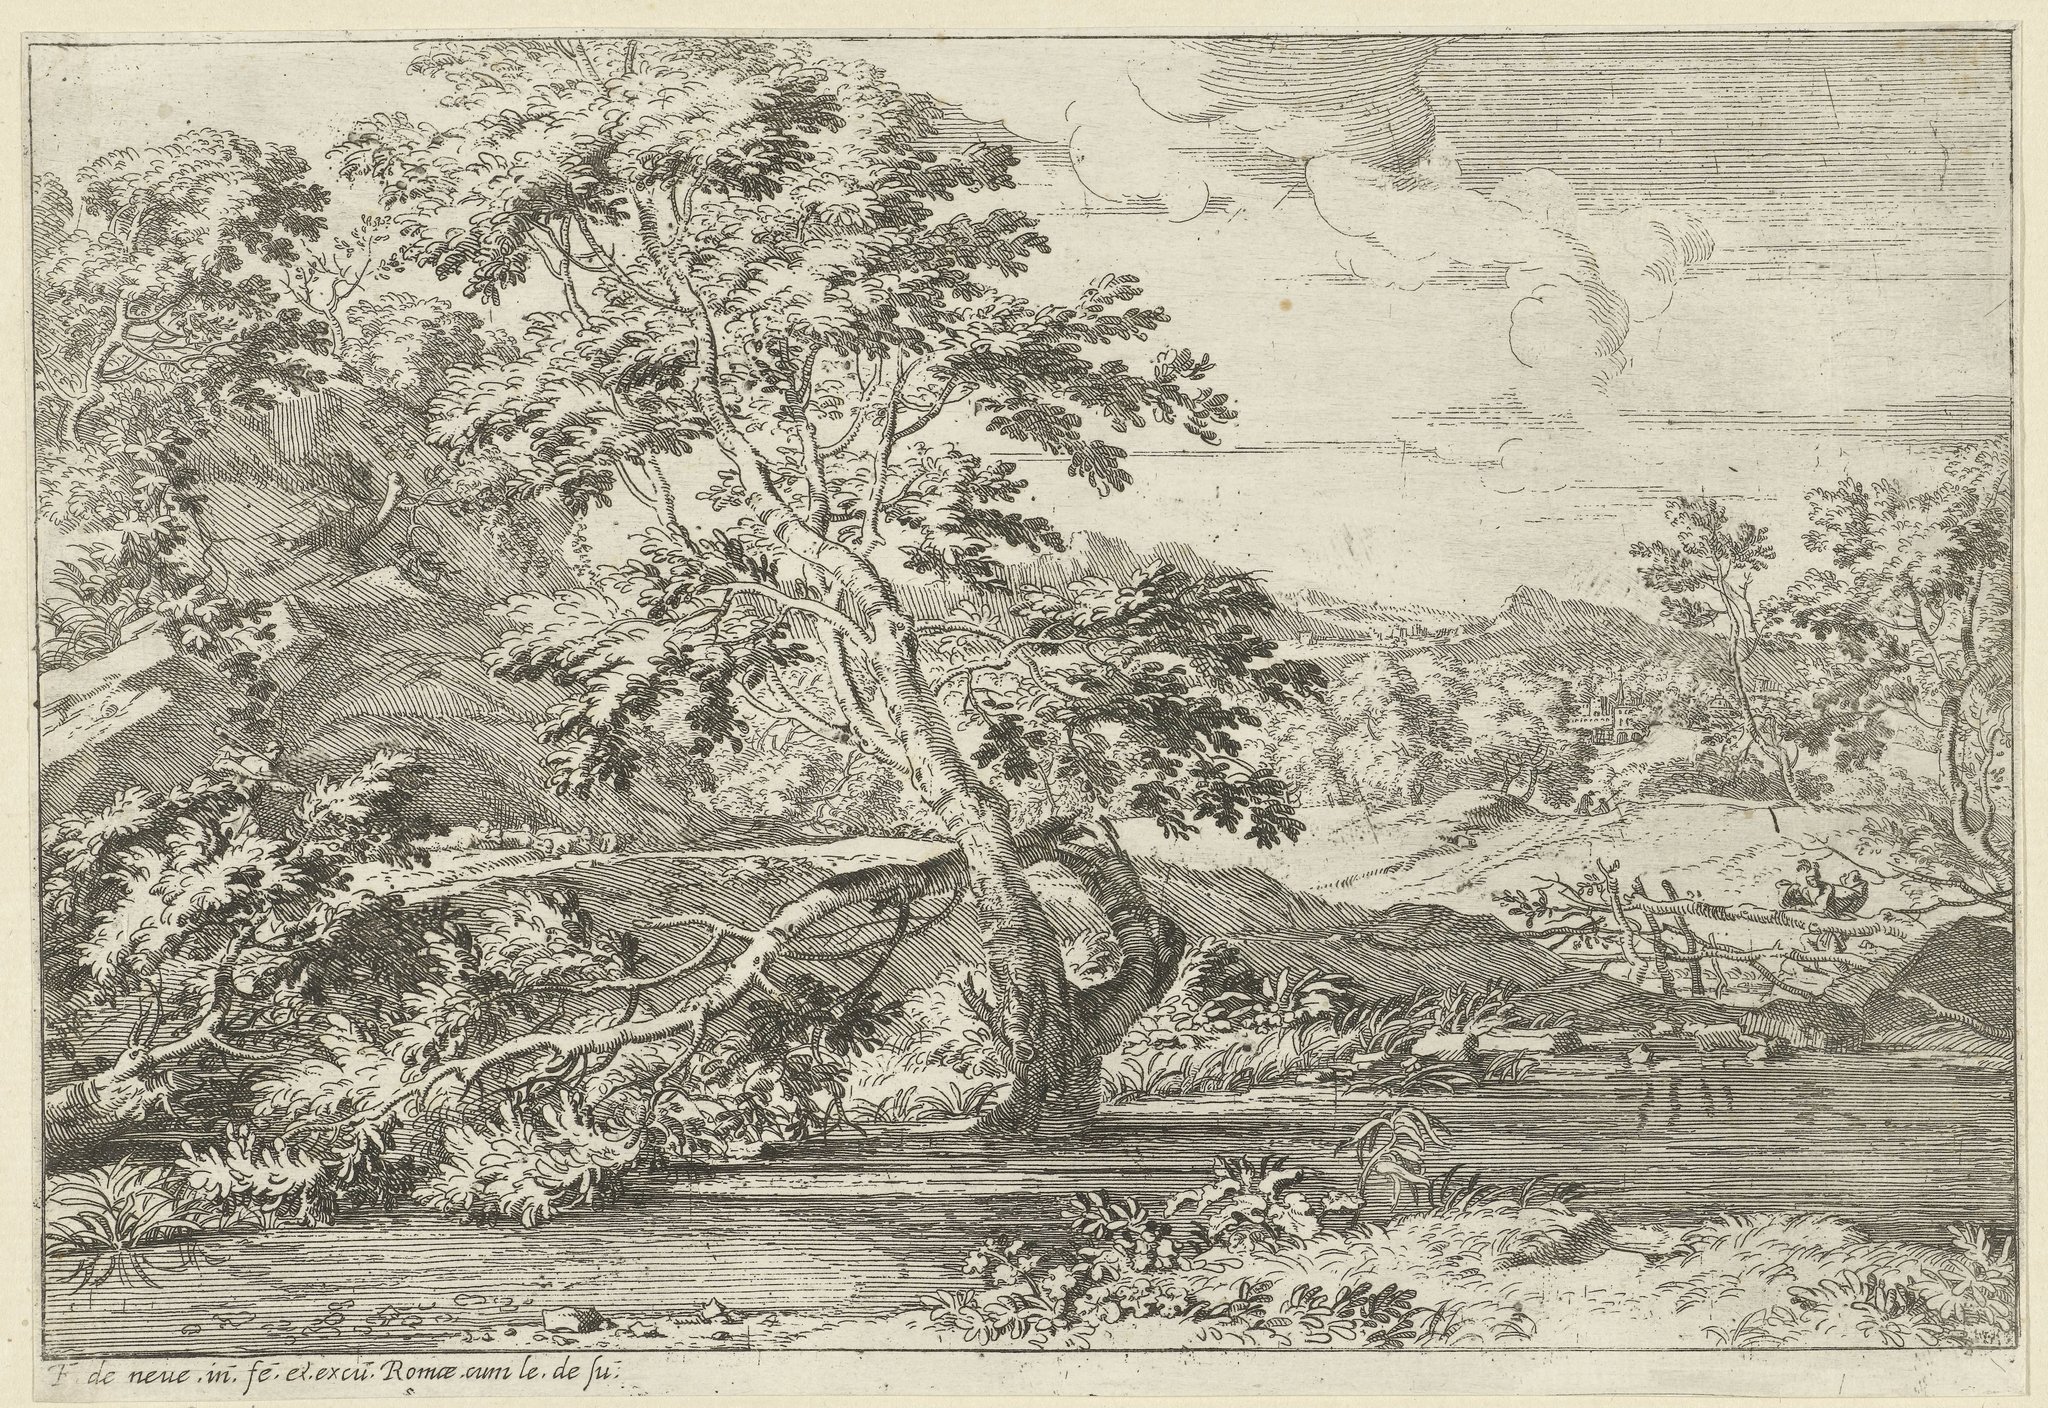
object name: print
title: Landschap met een boom in het water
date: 1660-1666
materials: paper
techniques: etching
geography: rome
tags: trees, fence, wall, paling, water course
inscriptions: collector's mark: Lugt 240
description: Heuvelachtig landschap met een boom met overhangende tak in het water.